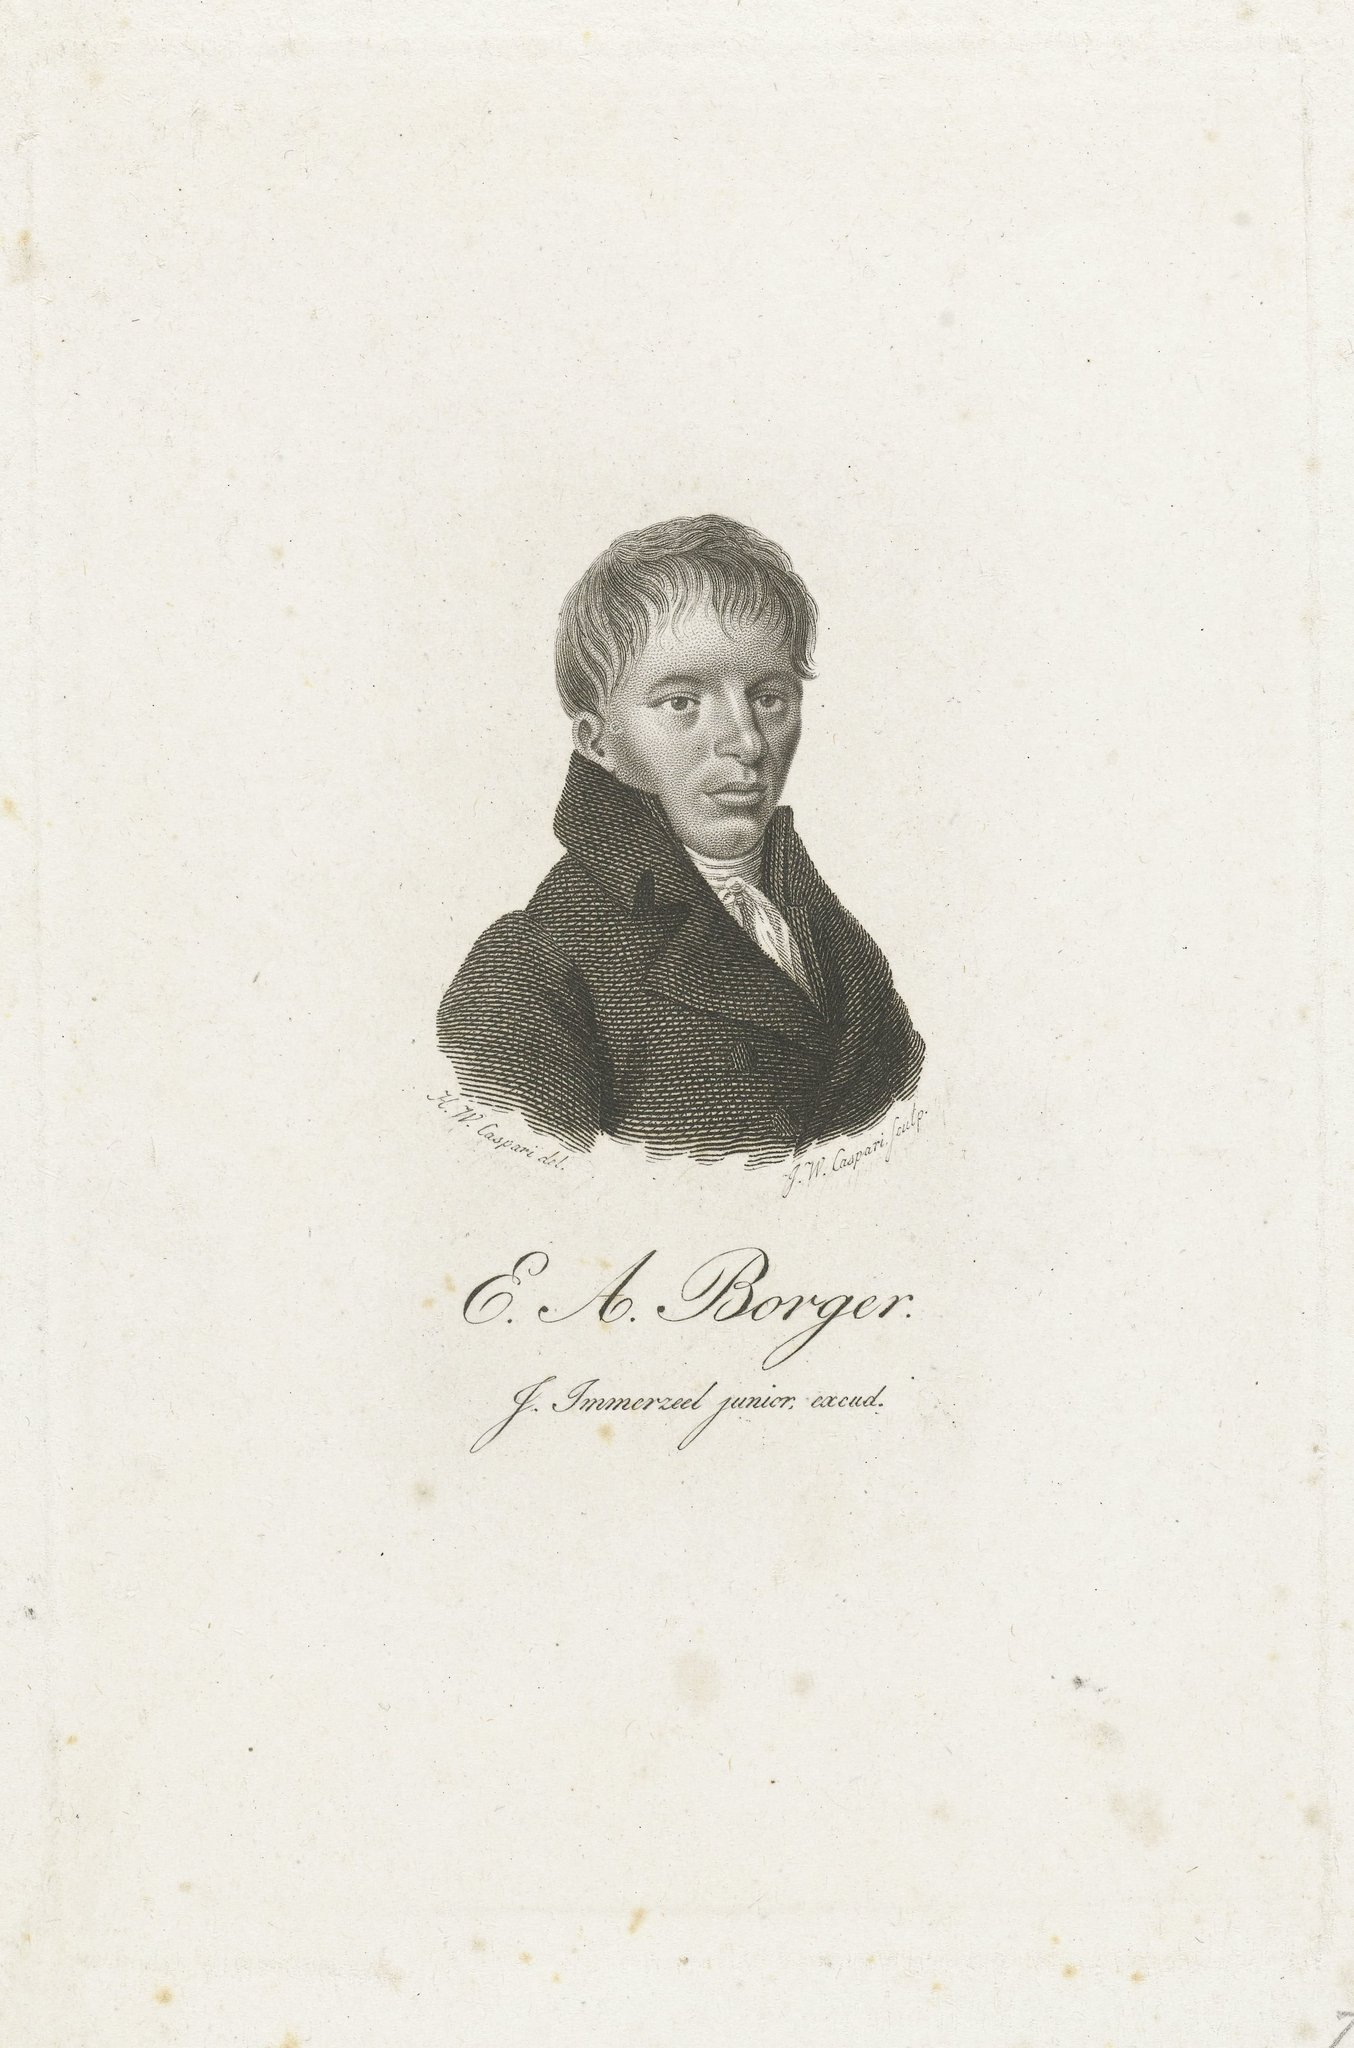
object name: print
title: Portret van Elias Annes Borger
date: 1789-1822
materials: paper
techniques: etching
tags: elias annes borger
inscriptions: collector's mark: Lugt 2228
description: Portret van Elias Annes Borger, een Noord-Nederlands dichter en hoogleraar aan de Leidse universiteit. Buste naar rechts. Hij draagt een zwarte jas met een hoge kraag. Onder de prent de naam van de geportretteerde.